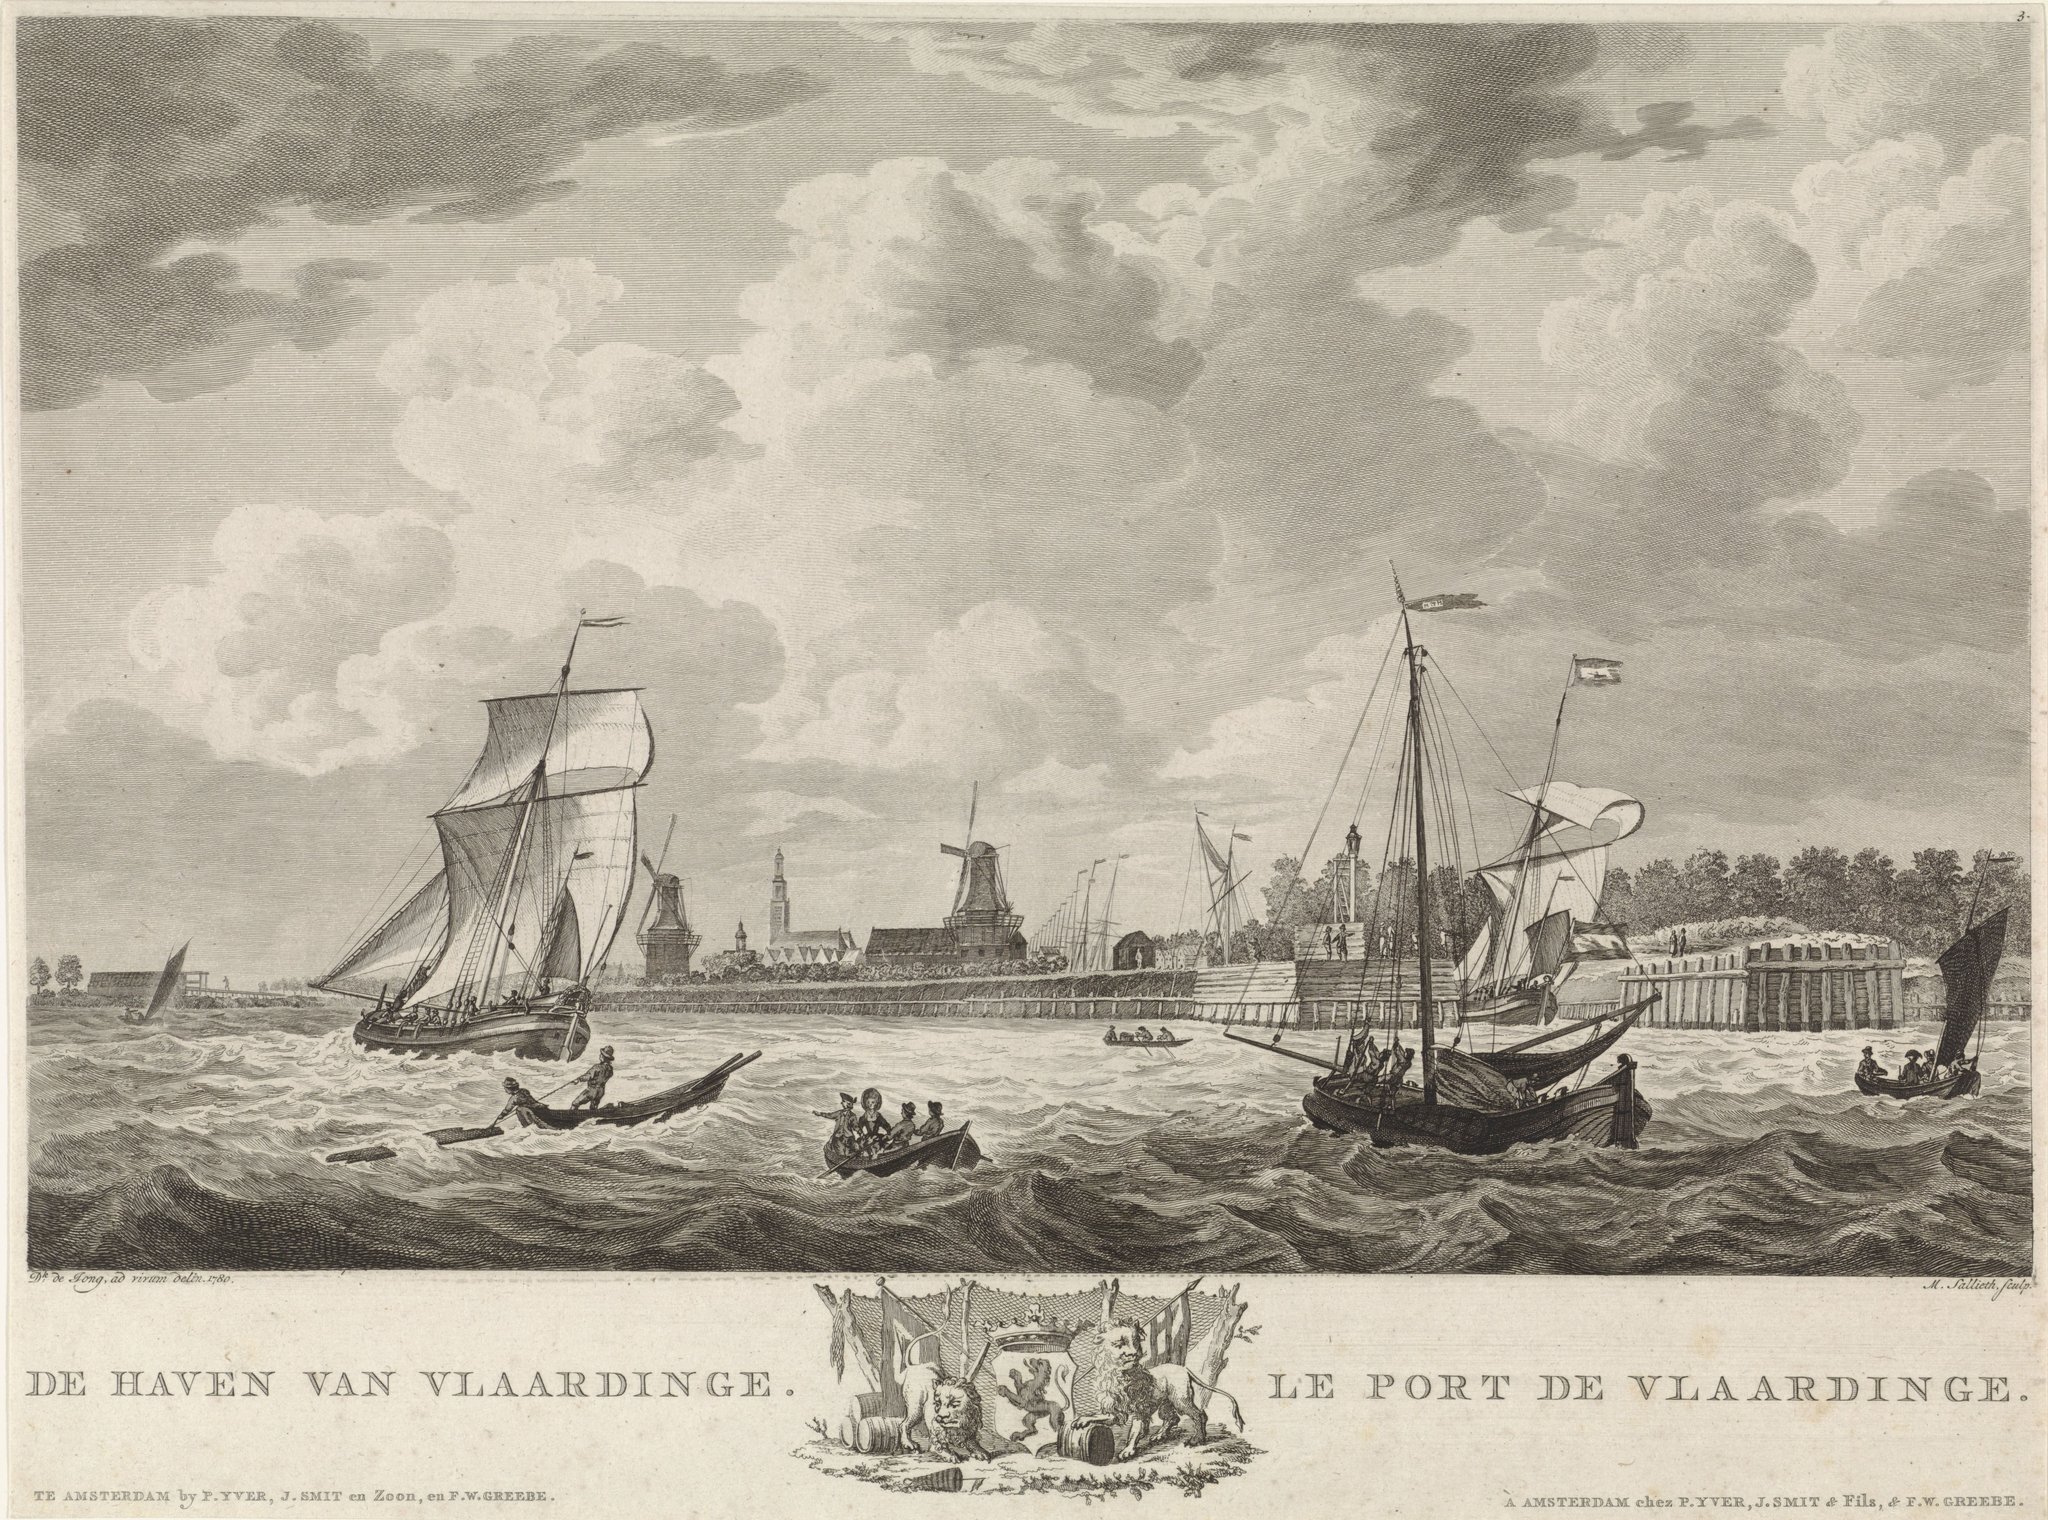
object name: print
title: De haven van Vlaardinge / Le port de Vlaardinge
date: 1780-1787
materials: paper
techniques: etching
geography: amsterdam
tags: harbour, coat of arms (as symbol of the state, etc.) (+ city; municipal), sailing-ship, sailing-boat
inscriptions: collector's mark: Lugt 2228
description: Latere staat ook gebruikt in: Aa, Cornelis van der. Atlas van de zeehavens der Bataafsche Republiek. Met derzelver beschrijvingen in XXXI kunstplaaten / Atlas van de zeehavens der Bataafsche Republiek, die van Batavia en Onrust. Mitsgaders de afbeeldingen van de haringvisscherij en de walvischvangst […]. Amsterdam: Evert Maaskamp, 1805.